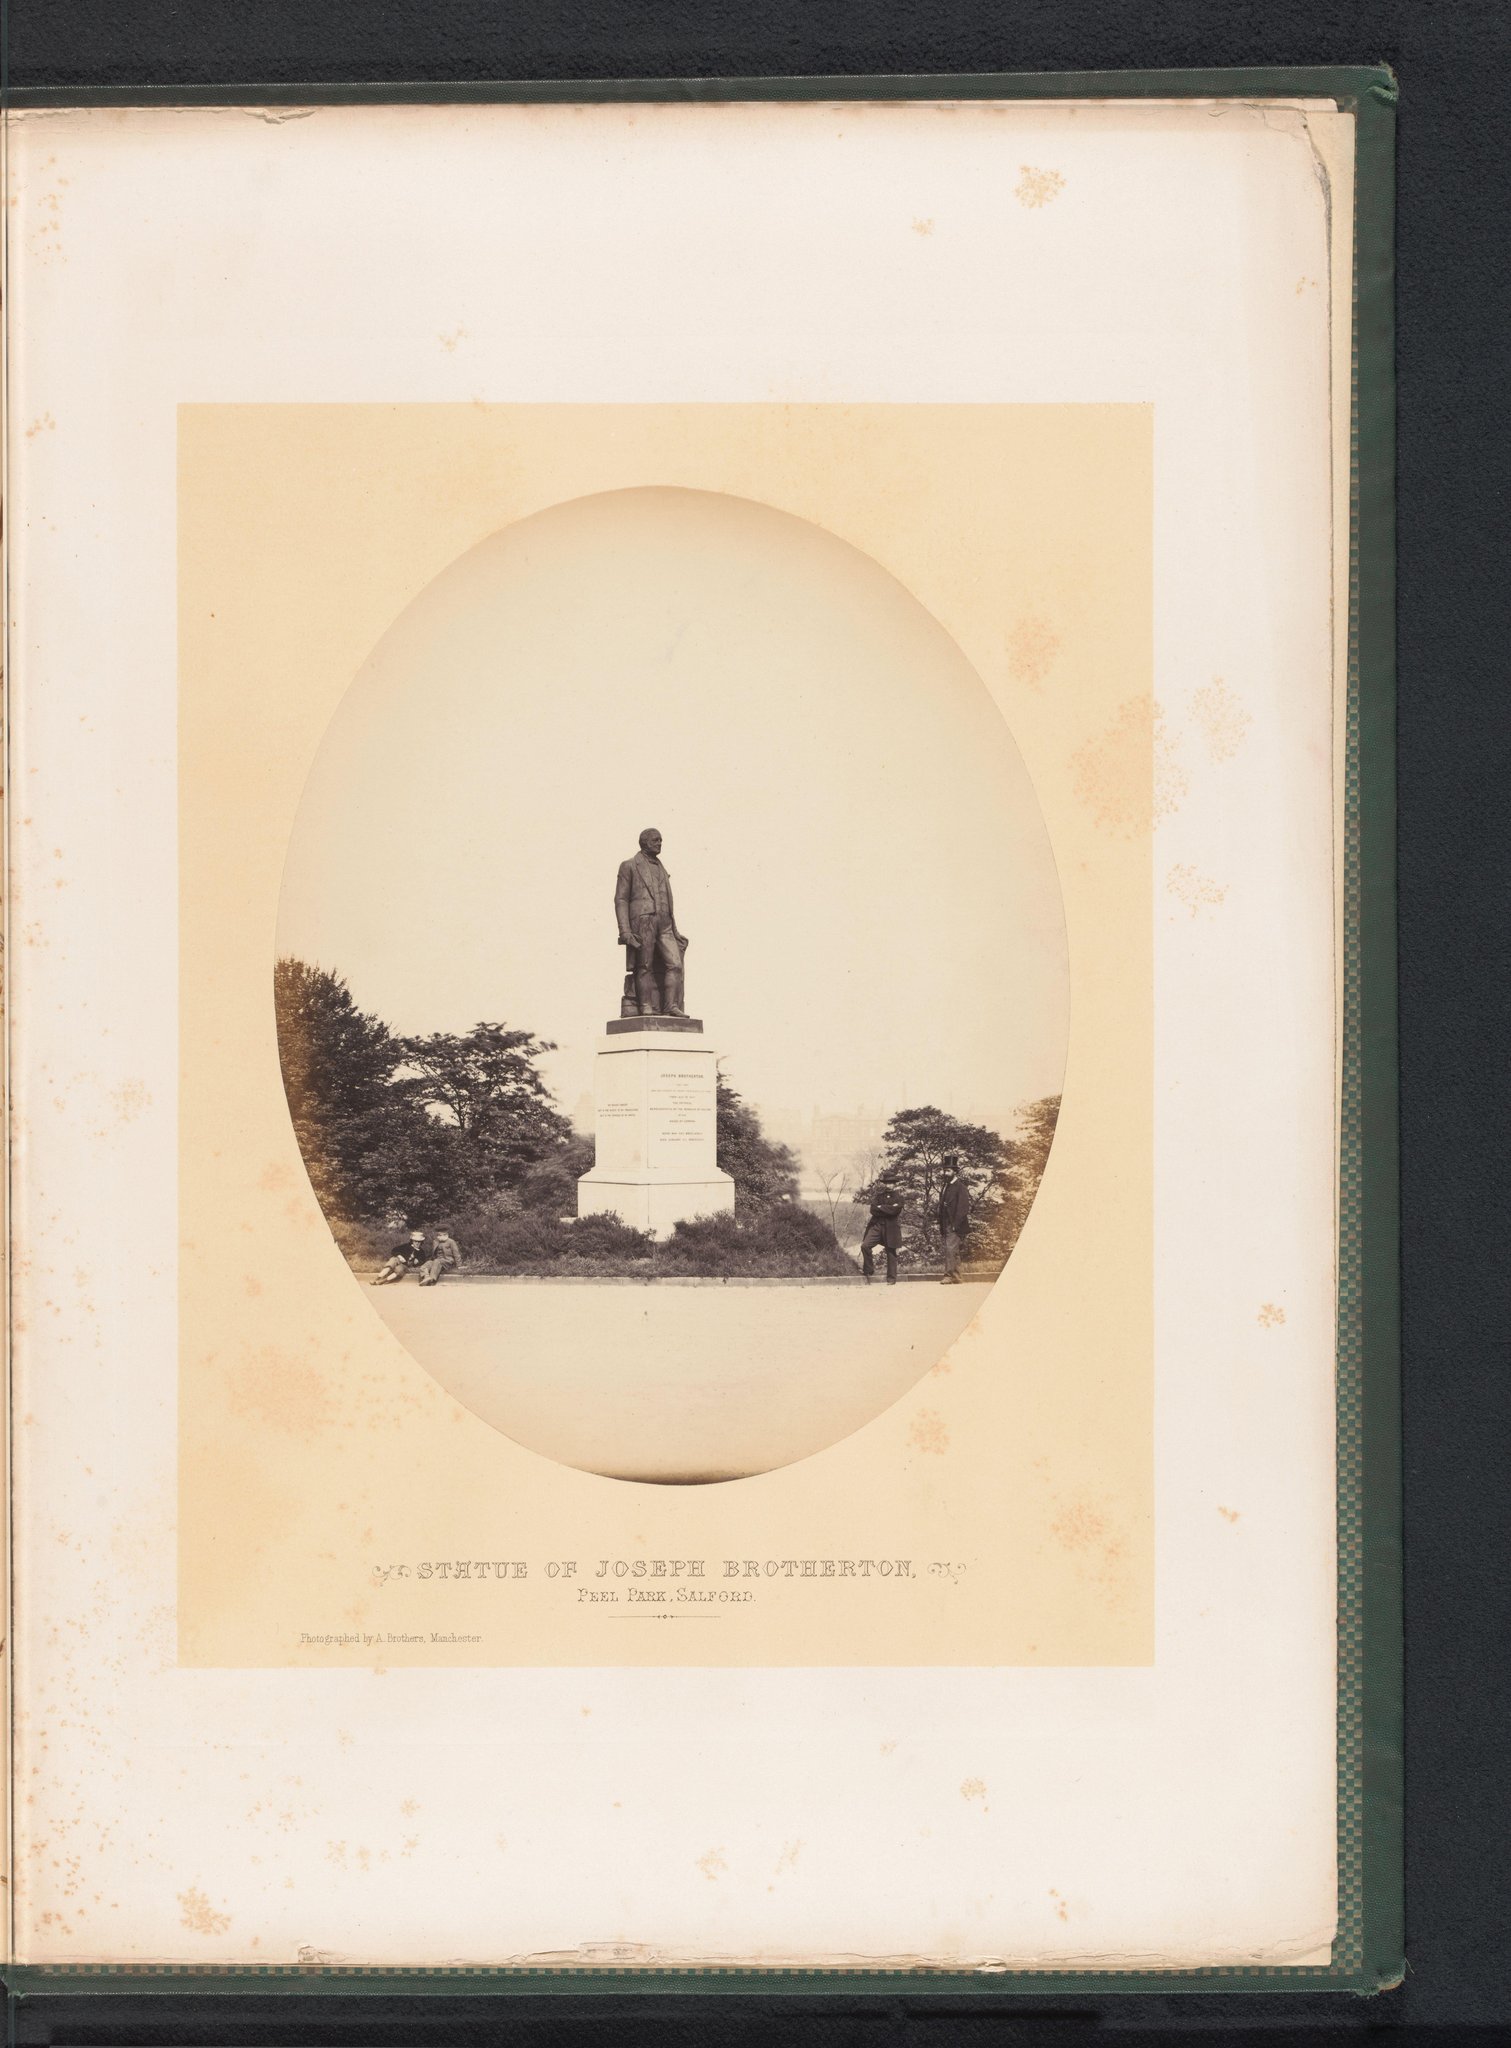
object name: page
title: Standbeeld van Joseph Brotherton in Peel Park in Salford, Engeland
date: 1863-1868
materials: photographic support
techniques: albumen print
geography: salford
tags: monument, statue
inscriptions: inscription: ‘Peel Park, Salford.’